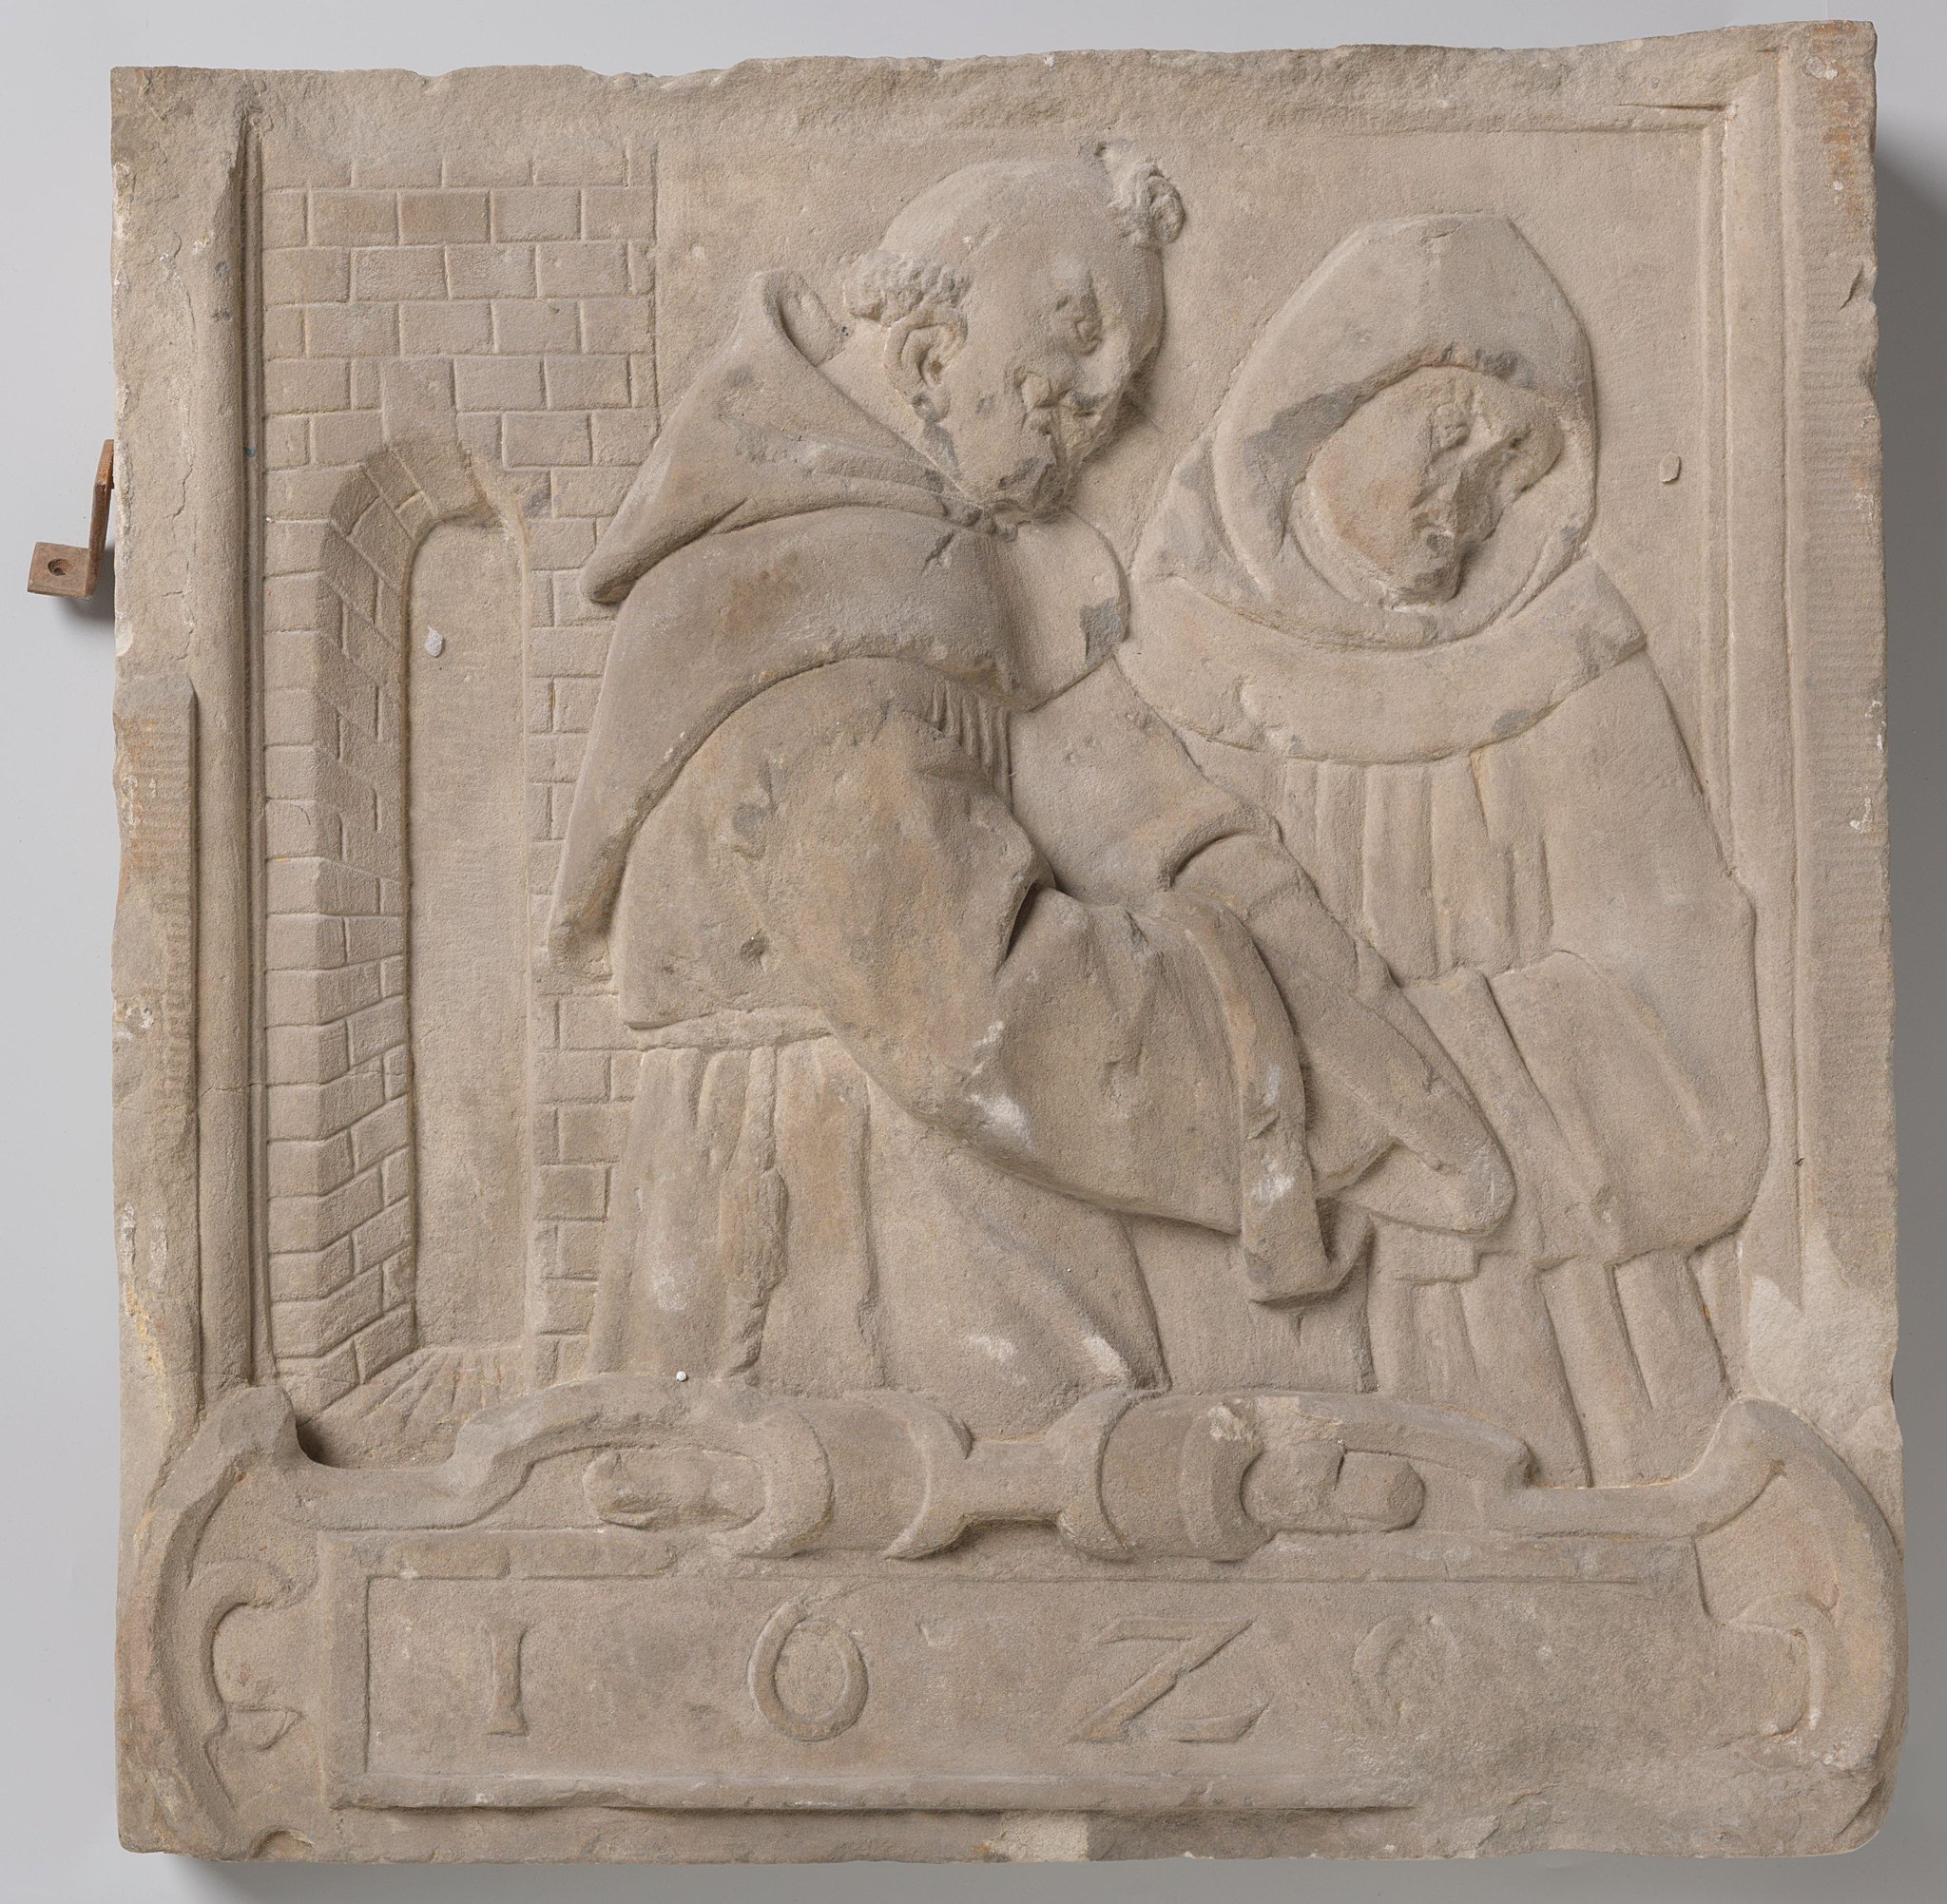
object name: gable stone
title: Gevelsteen met twee monniken ten halve lijven en jaartal 16.(?)0.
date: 1600-1699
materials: stone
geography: netherlands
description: Vierkant met een links een nis in een bakstenen muur en rechts twee monniken ten halven lijve. De rechter monnik heeft een kap op zijn hoofd. Langs de onderrand een cartouche met rolwerk waarbinnen een jaartal 16ZO(?).